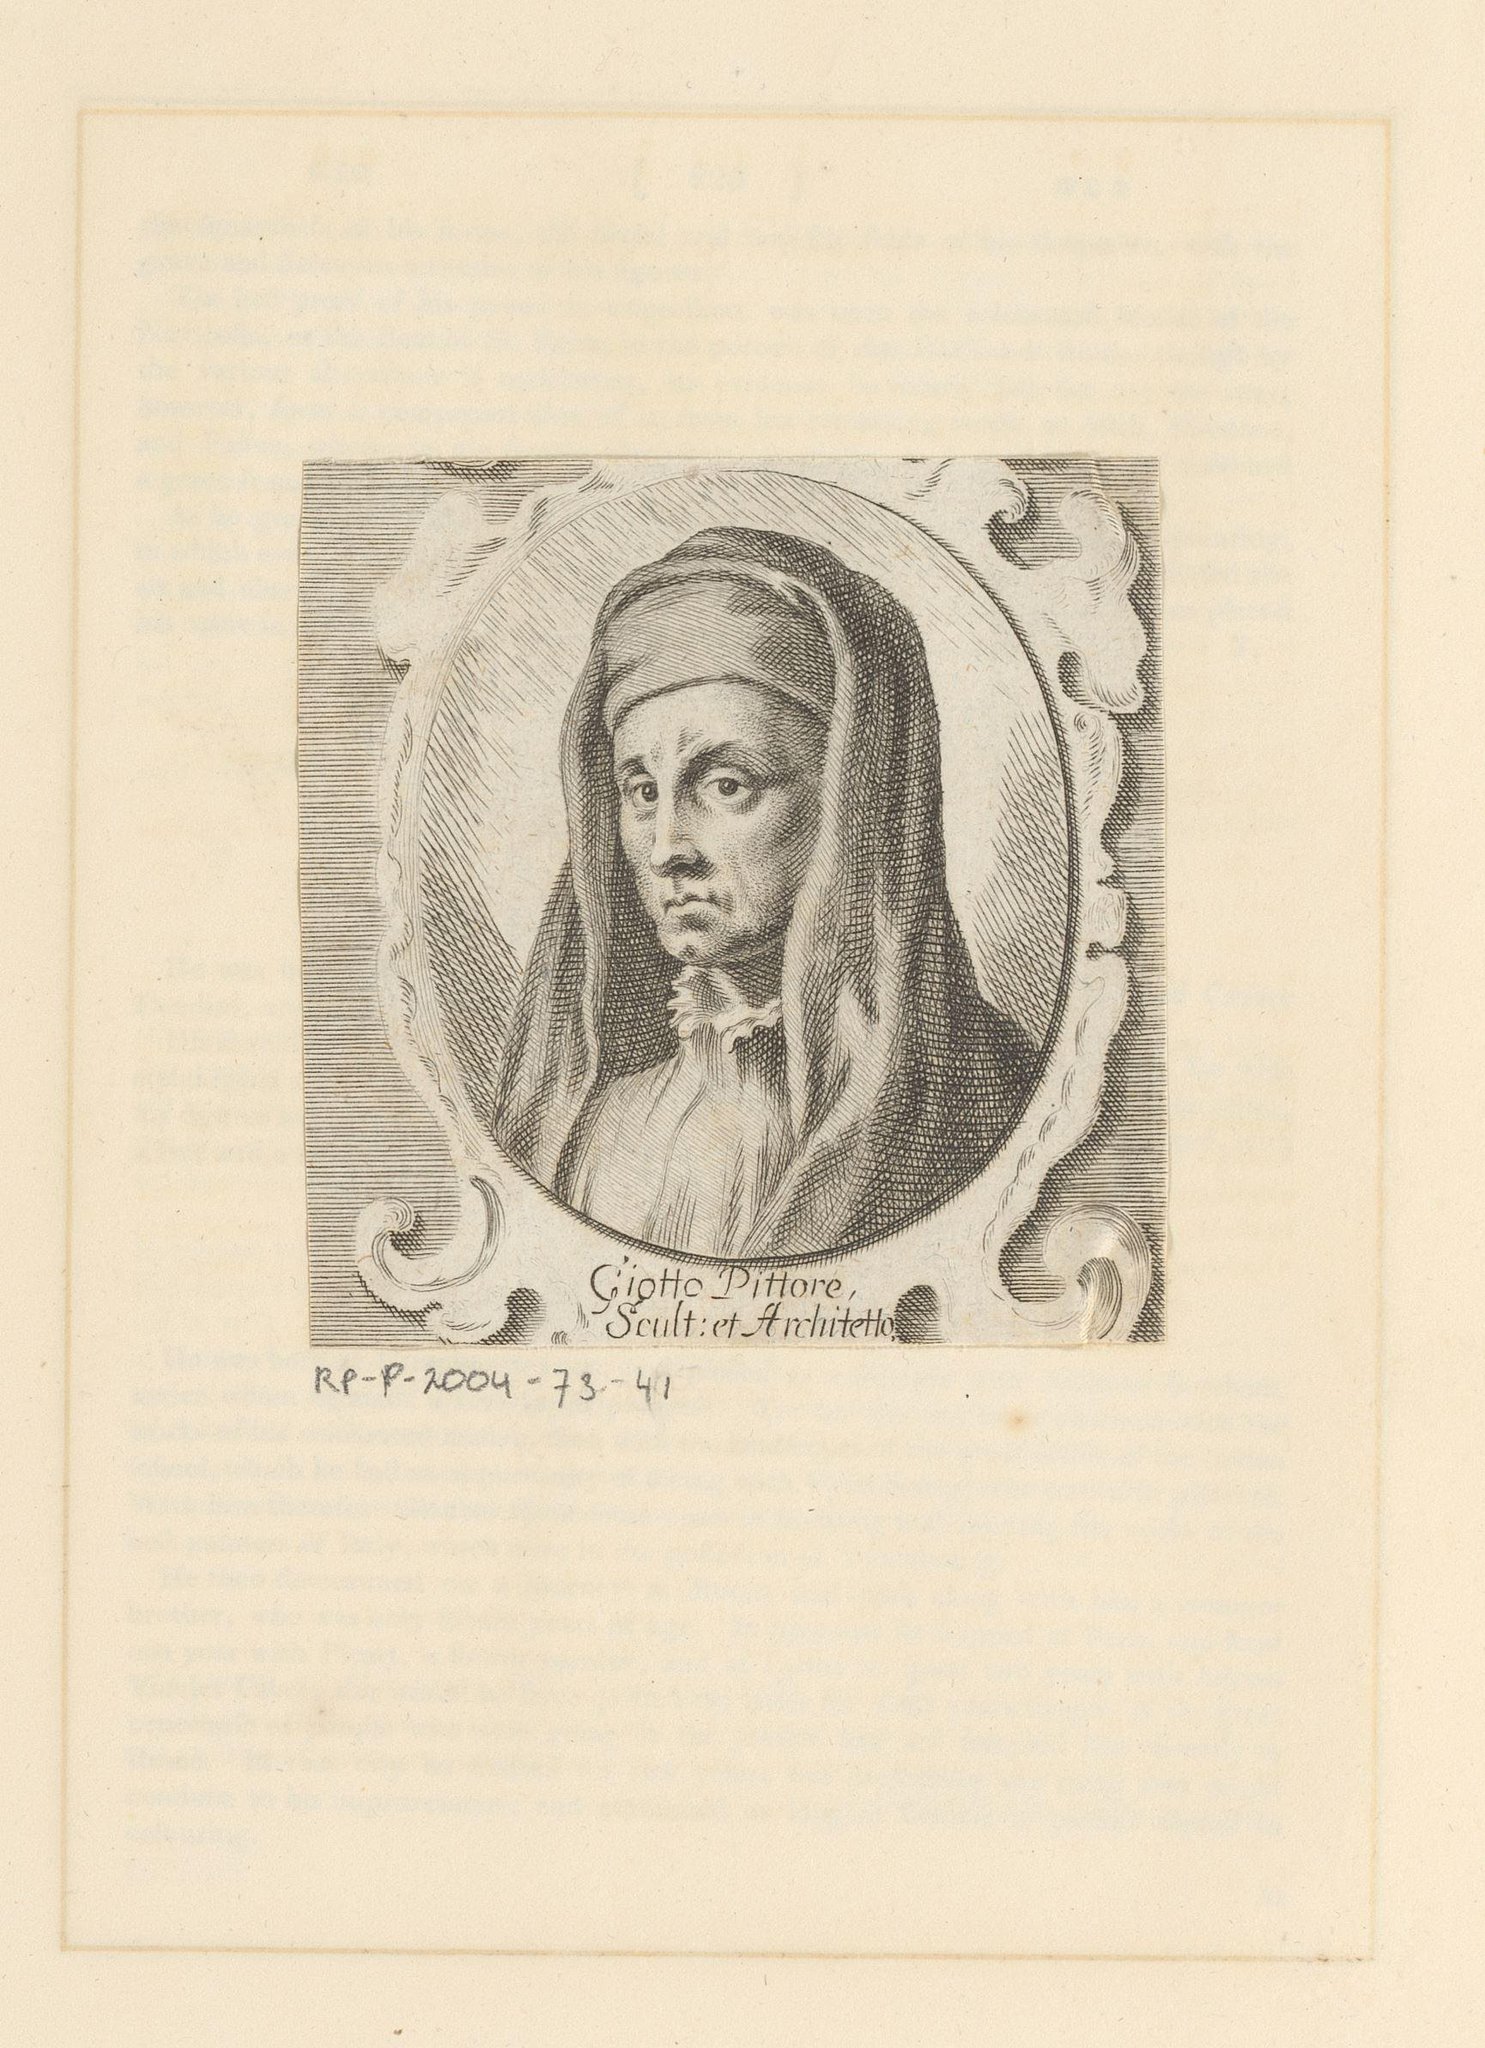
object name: book illustration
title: Portret van Giotto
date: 1675-1679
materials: paper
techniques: engraving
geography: nuremberg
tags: sculptor, giotto de bondone, historical persons, portrait, self-portrait of painter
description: Prent uit: Sandrart, Joachim von. Teutsche Academie der Edlen Bau- Bild- und Mahlerey-Künste (...). Neurenberg: Jakob von Sandrart, [1675-1679], dl. 1, p. 60. Latere staat van de prent gebruikt in: Sandrart, Joachim von. Teutsche Academie der Bau- Bildhauer- und Maler-Kunst: worinn die Regeln und Lehrsätze dieser Künste gegeben. 14 dln. Neurenberg: erven Johann Andreas Endter, [1774], dl. 7, p. I. De samensteller heeft deze prent in het album geplakt als illustratie bij: Pilkington, Matthew en Johann Heinrich Füssli. A dictionary of painters, from the revival of the art to the present period. 4 dln. Londen: John Crowder, 1805, dl. 2, p. 222.